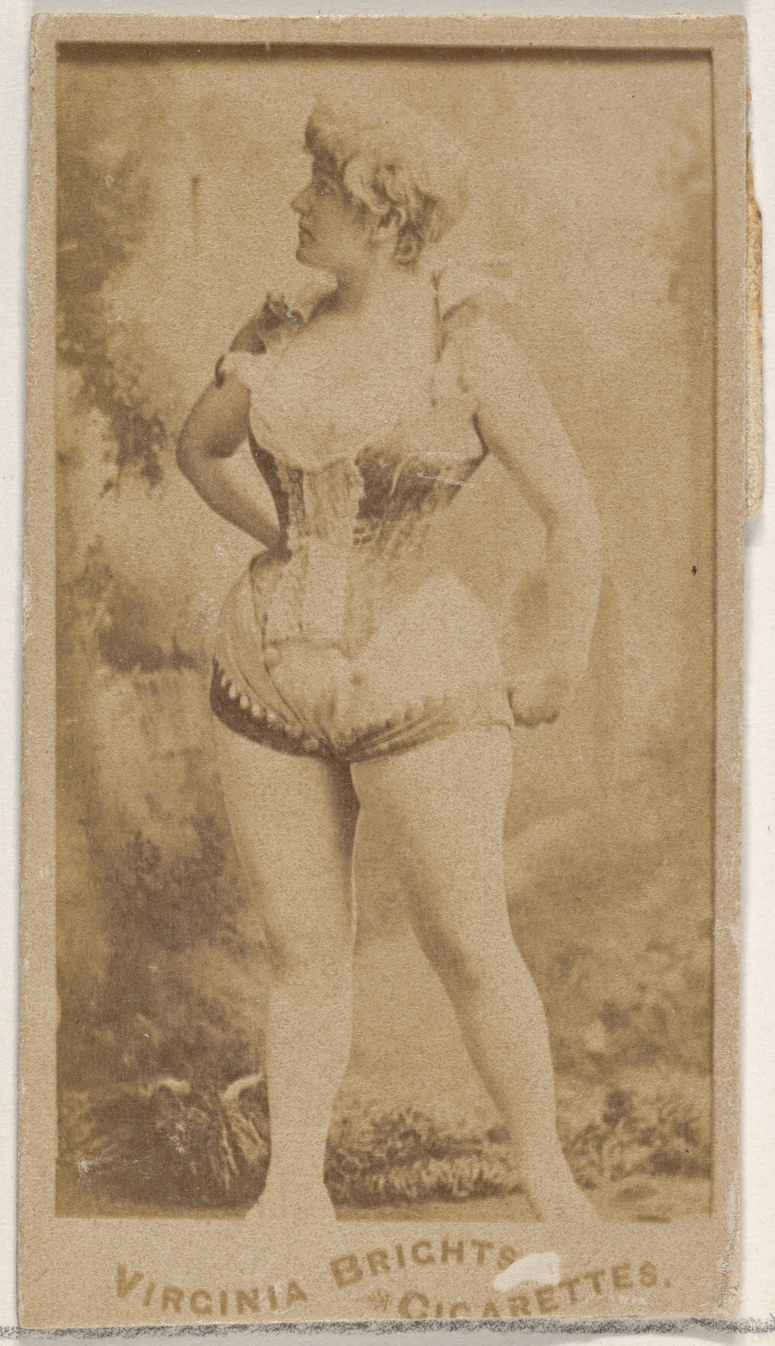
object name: photograph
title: From the Actors and Actresses series (N45, Type 5) for Virginia Brights Cigarettes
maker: allen & ginter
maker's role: publisher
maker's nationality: american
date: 1888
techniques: albumen silver print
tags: women,actresses